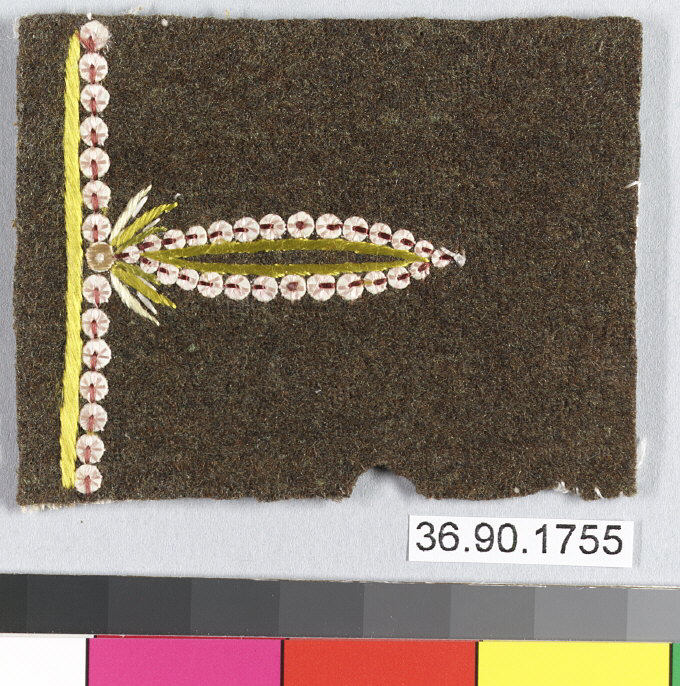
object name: sample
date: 1801-1833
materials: felt, silk